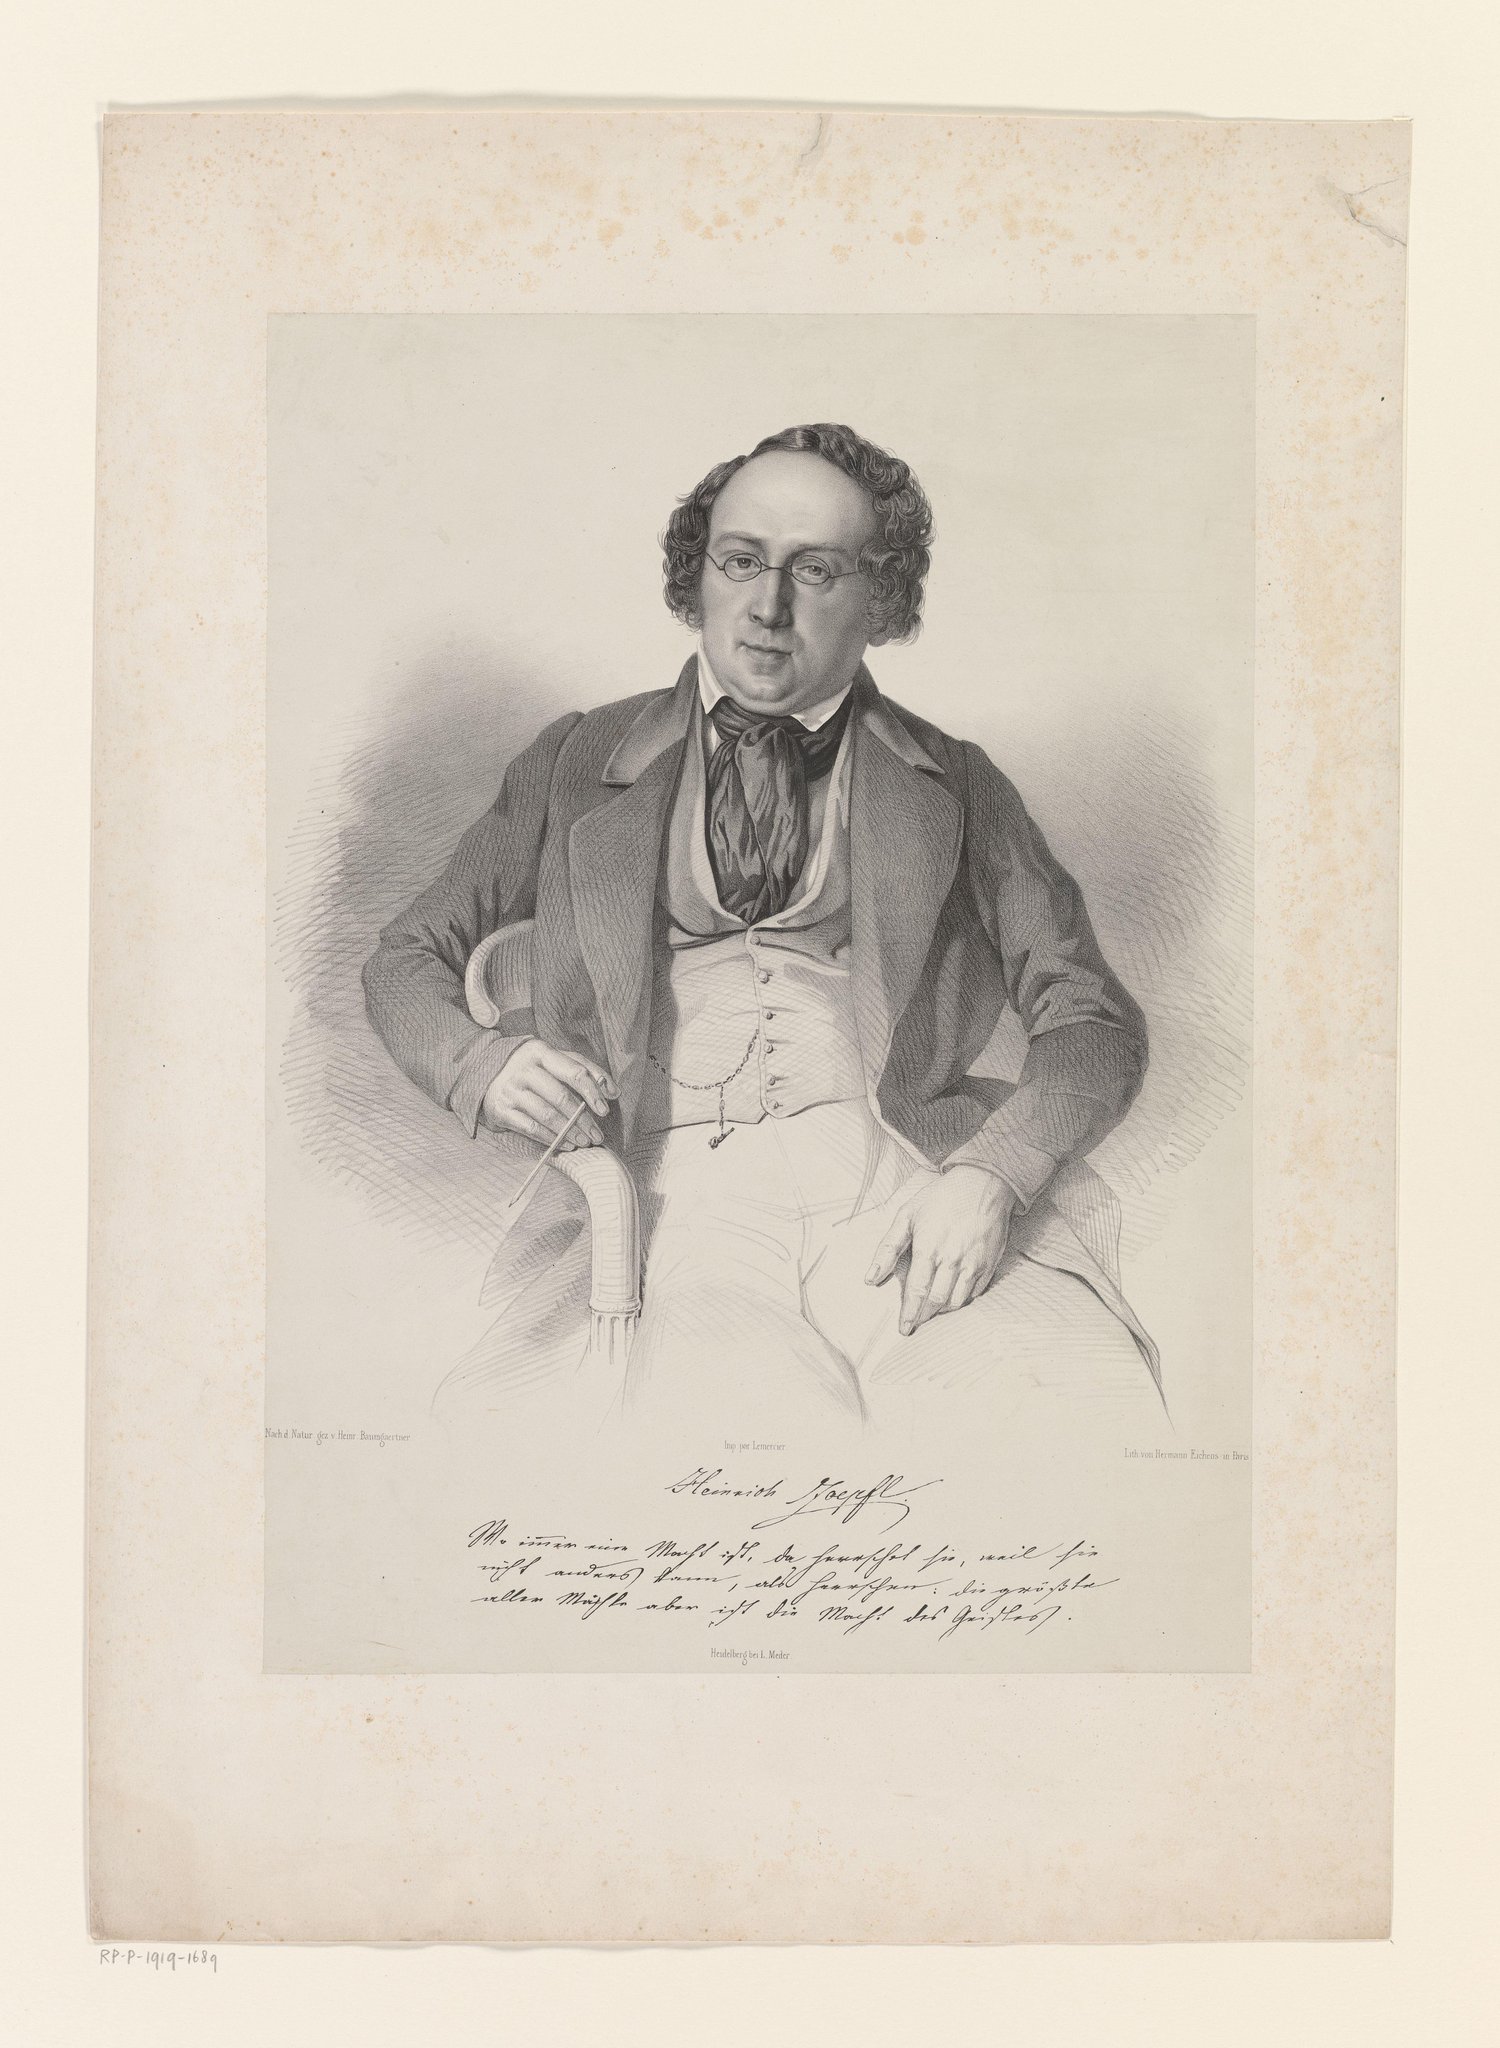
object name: print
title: Portret van Heinrich Zöpfl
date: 1823-1886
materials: paper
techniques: lithograph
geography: heidelberg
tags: eyeglasses, spectacles, adult man, historical persons, pencil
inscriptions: collector's mark: Lugt 2228